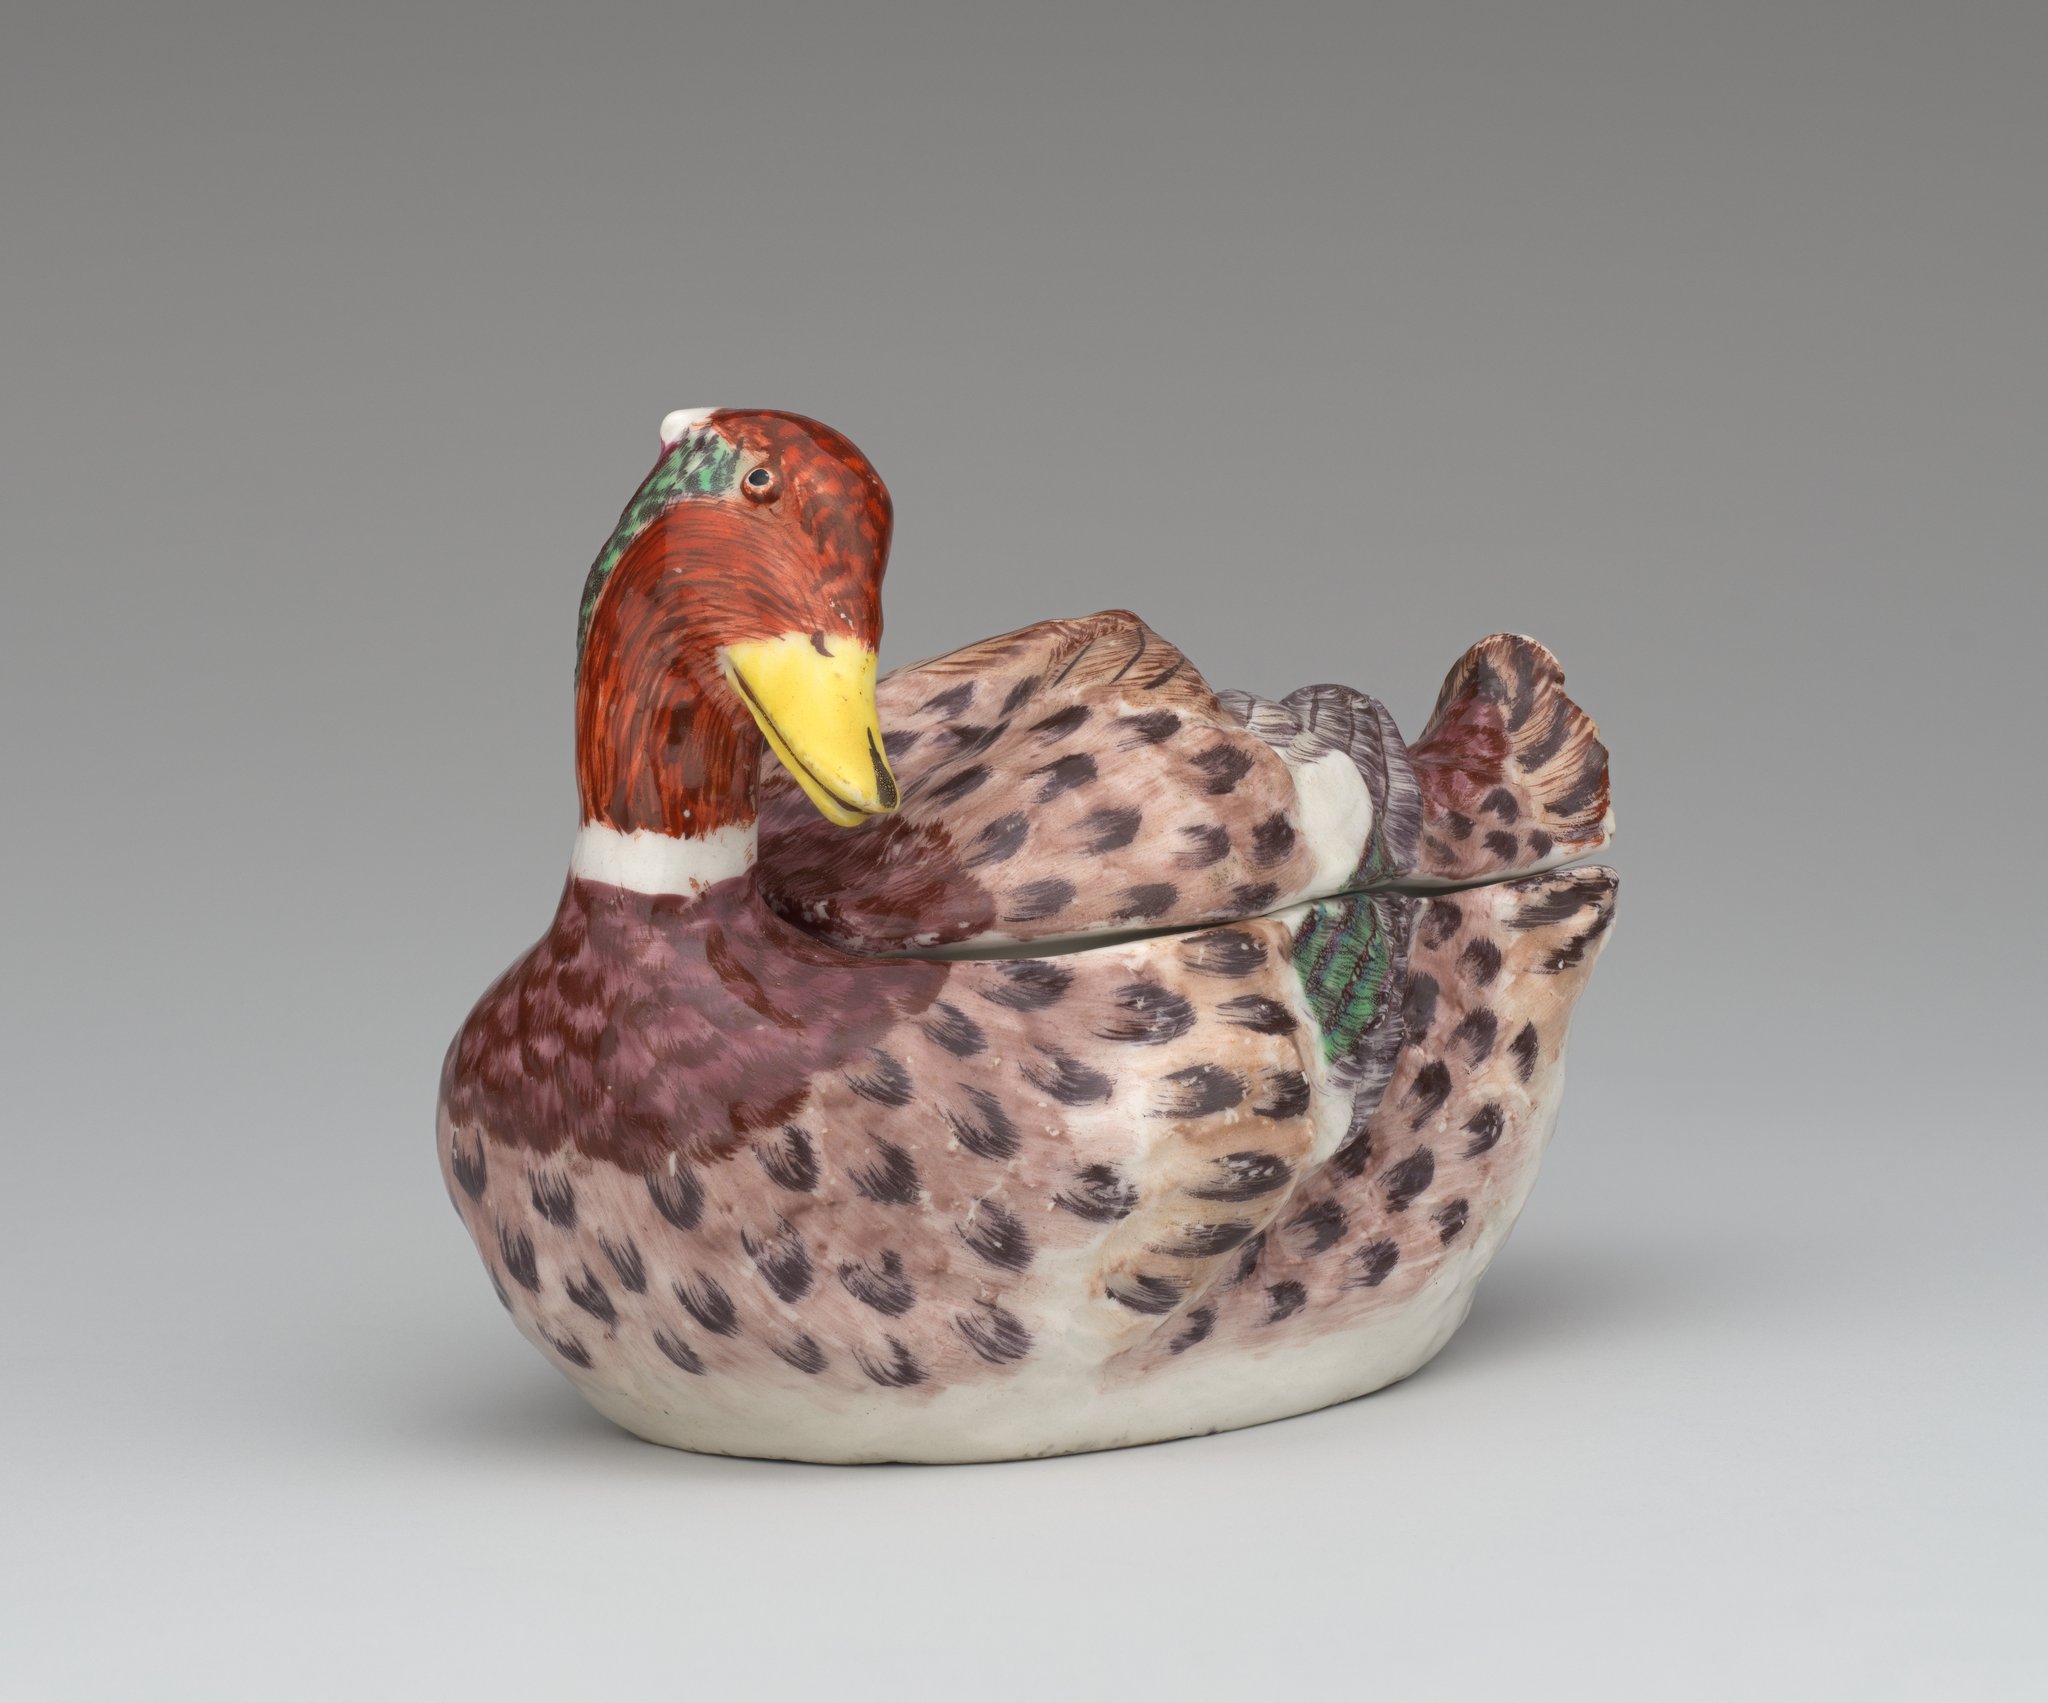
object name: tureen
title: Miniature tureen in the form of a duck (one of a pair)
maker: bow porcelain factory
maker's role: factory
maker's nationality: british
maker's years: 1747-1776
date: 1752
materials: soft paste porcelain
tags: ducks